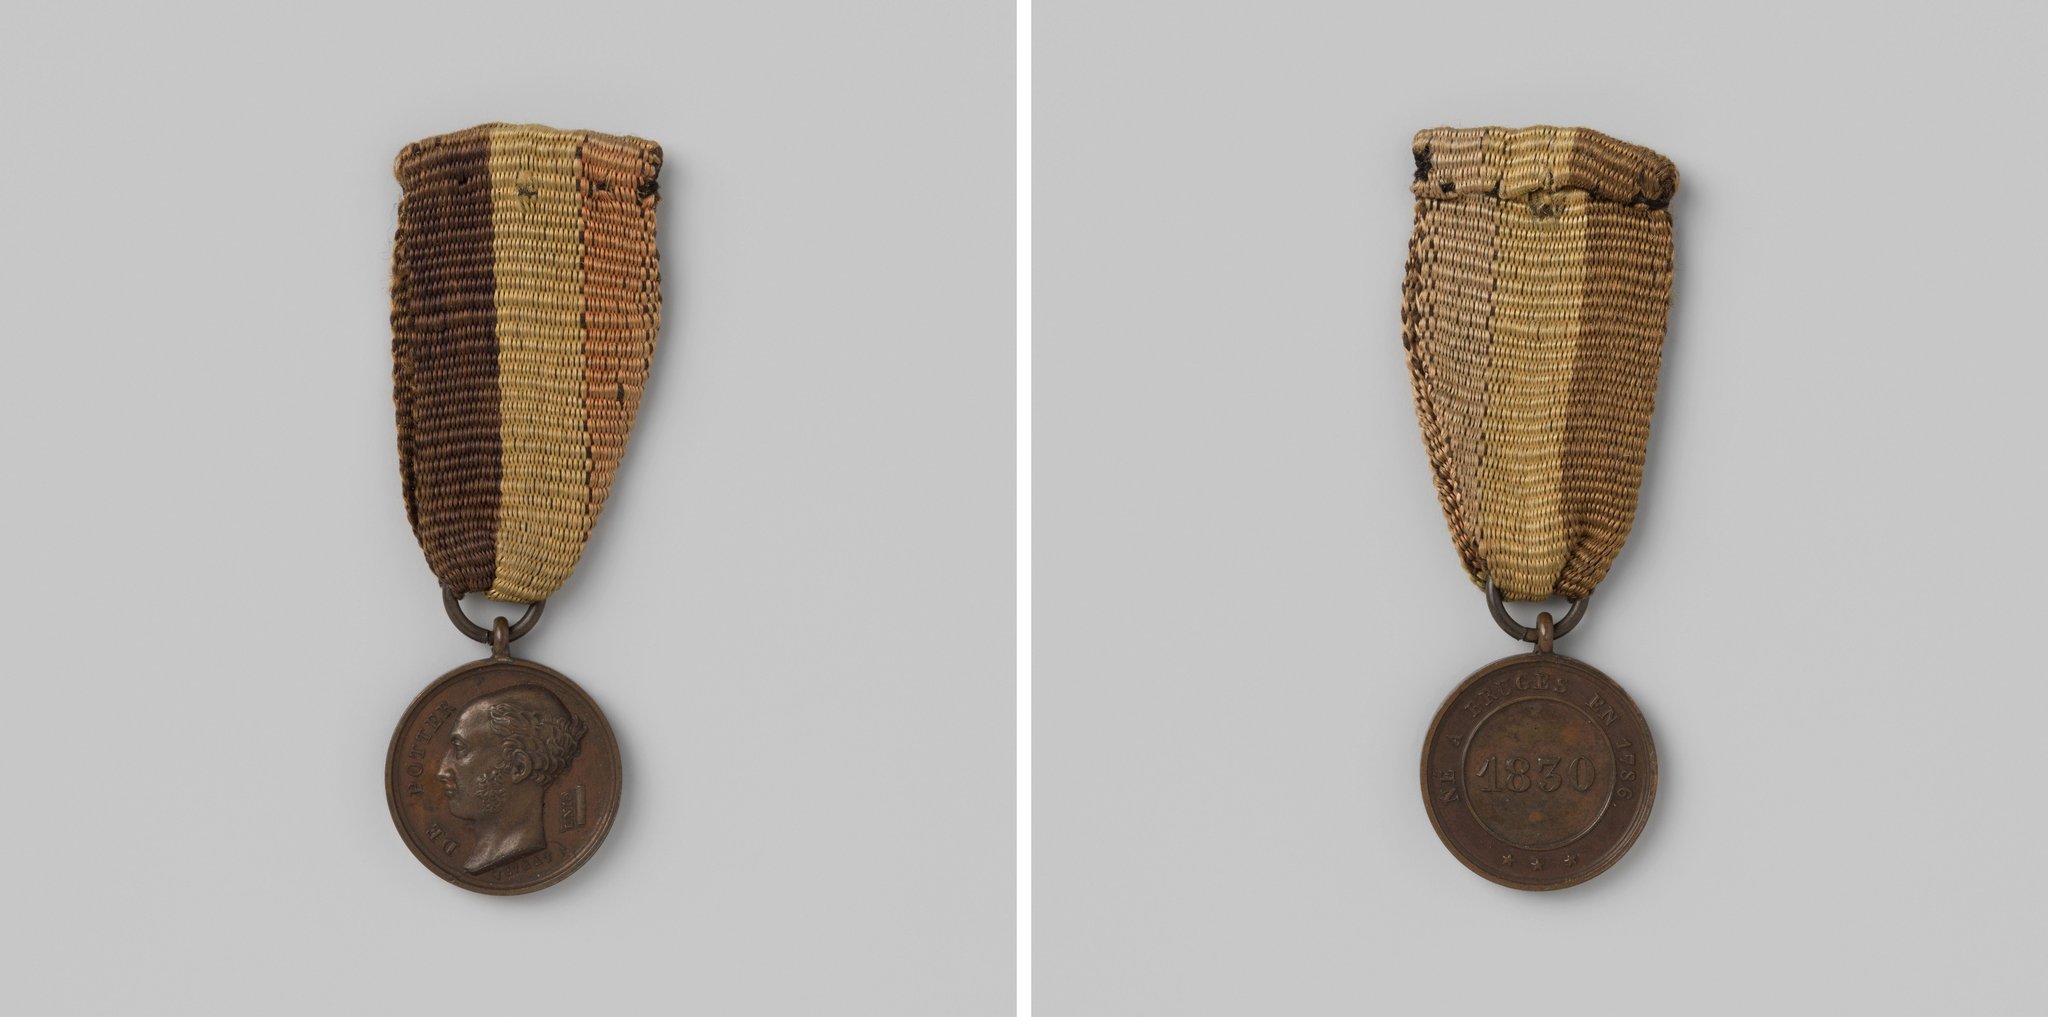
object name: insignia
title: Louis Joseph de Potter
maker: adrien hippolyte veyrat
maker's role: medailleur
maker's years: 1803-1883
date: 1830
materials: bronze, textile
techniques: striking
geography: brussels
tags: bruges, politician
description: Bronzen draagteken aan draagoog, draagring en zwart-geel-rood lint. Voorzijde: borststuk man; rechts daarvan een voor de helft ontrold papier met opschrift binnen omschrift. Keerzijde: jaartal binnen omschrift.